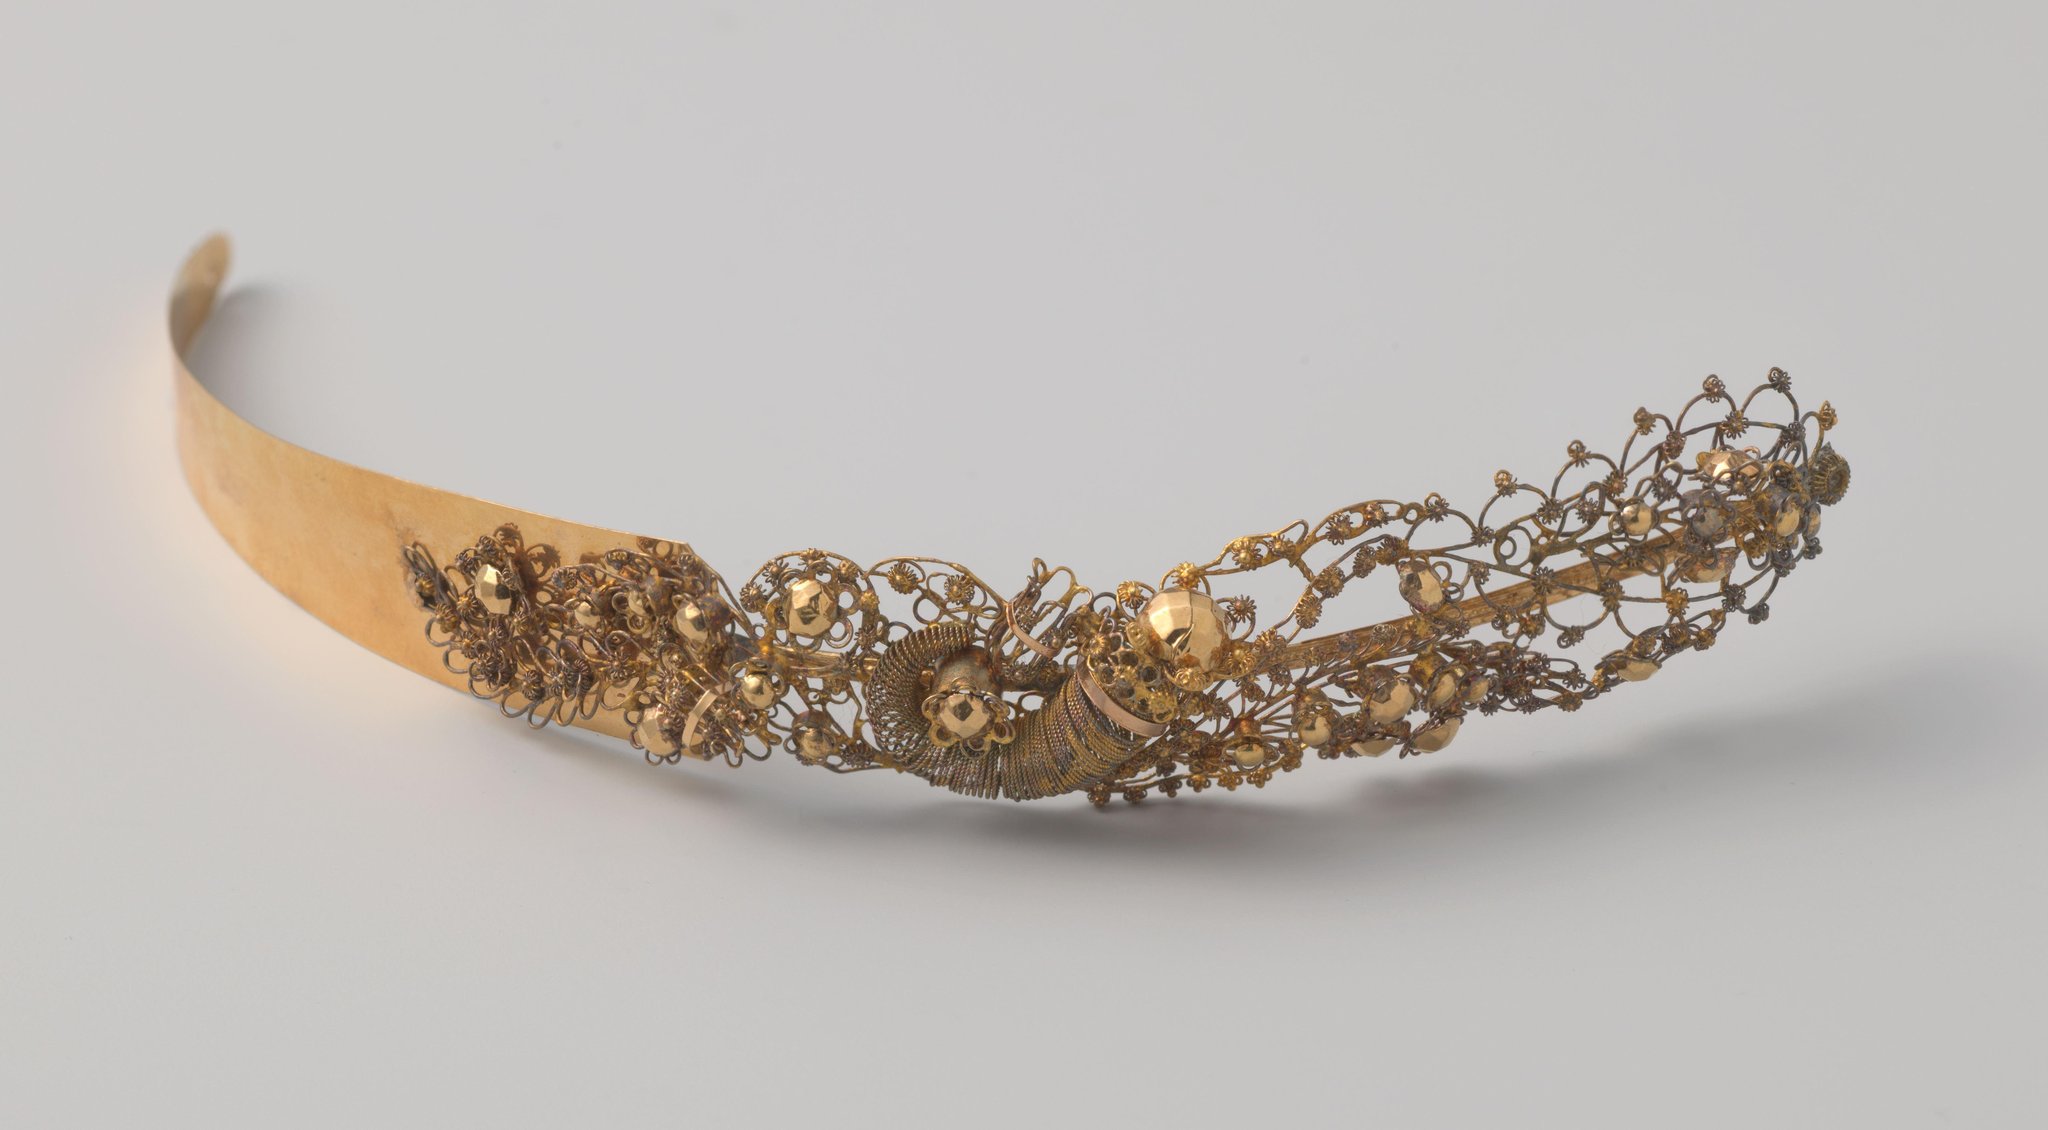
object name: streeksieraad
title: Voornaald van goud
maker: s. greeuw jzn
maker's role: jeweler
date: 1864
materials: gold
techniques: filigree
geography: hoorn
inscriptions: mark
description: Een gouden voornaald, aan de voorzijde versierd met takken en rozetten in filigrein. Afkomstig van een Oud-Zaans kapstel.